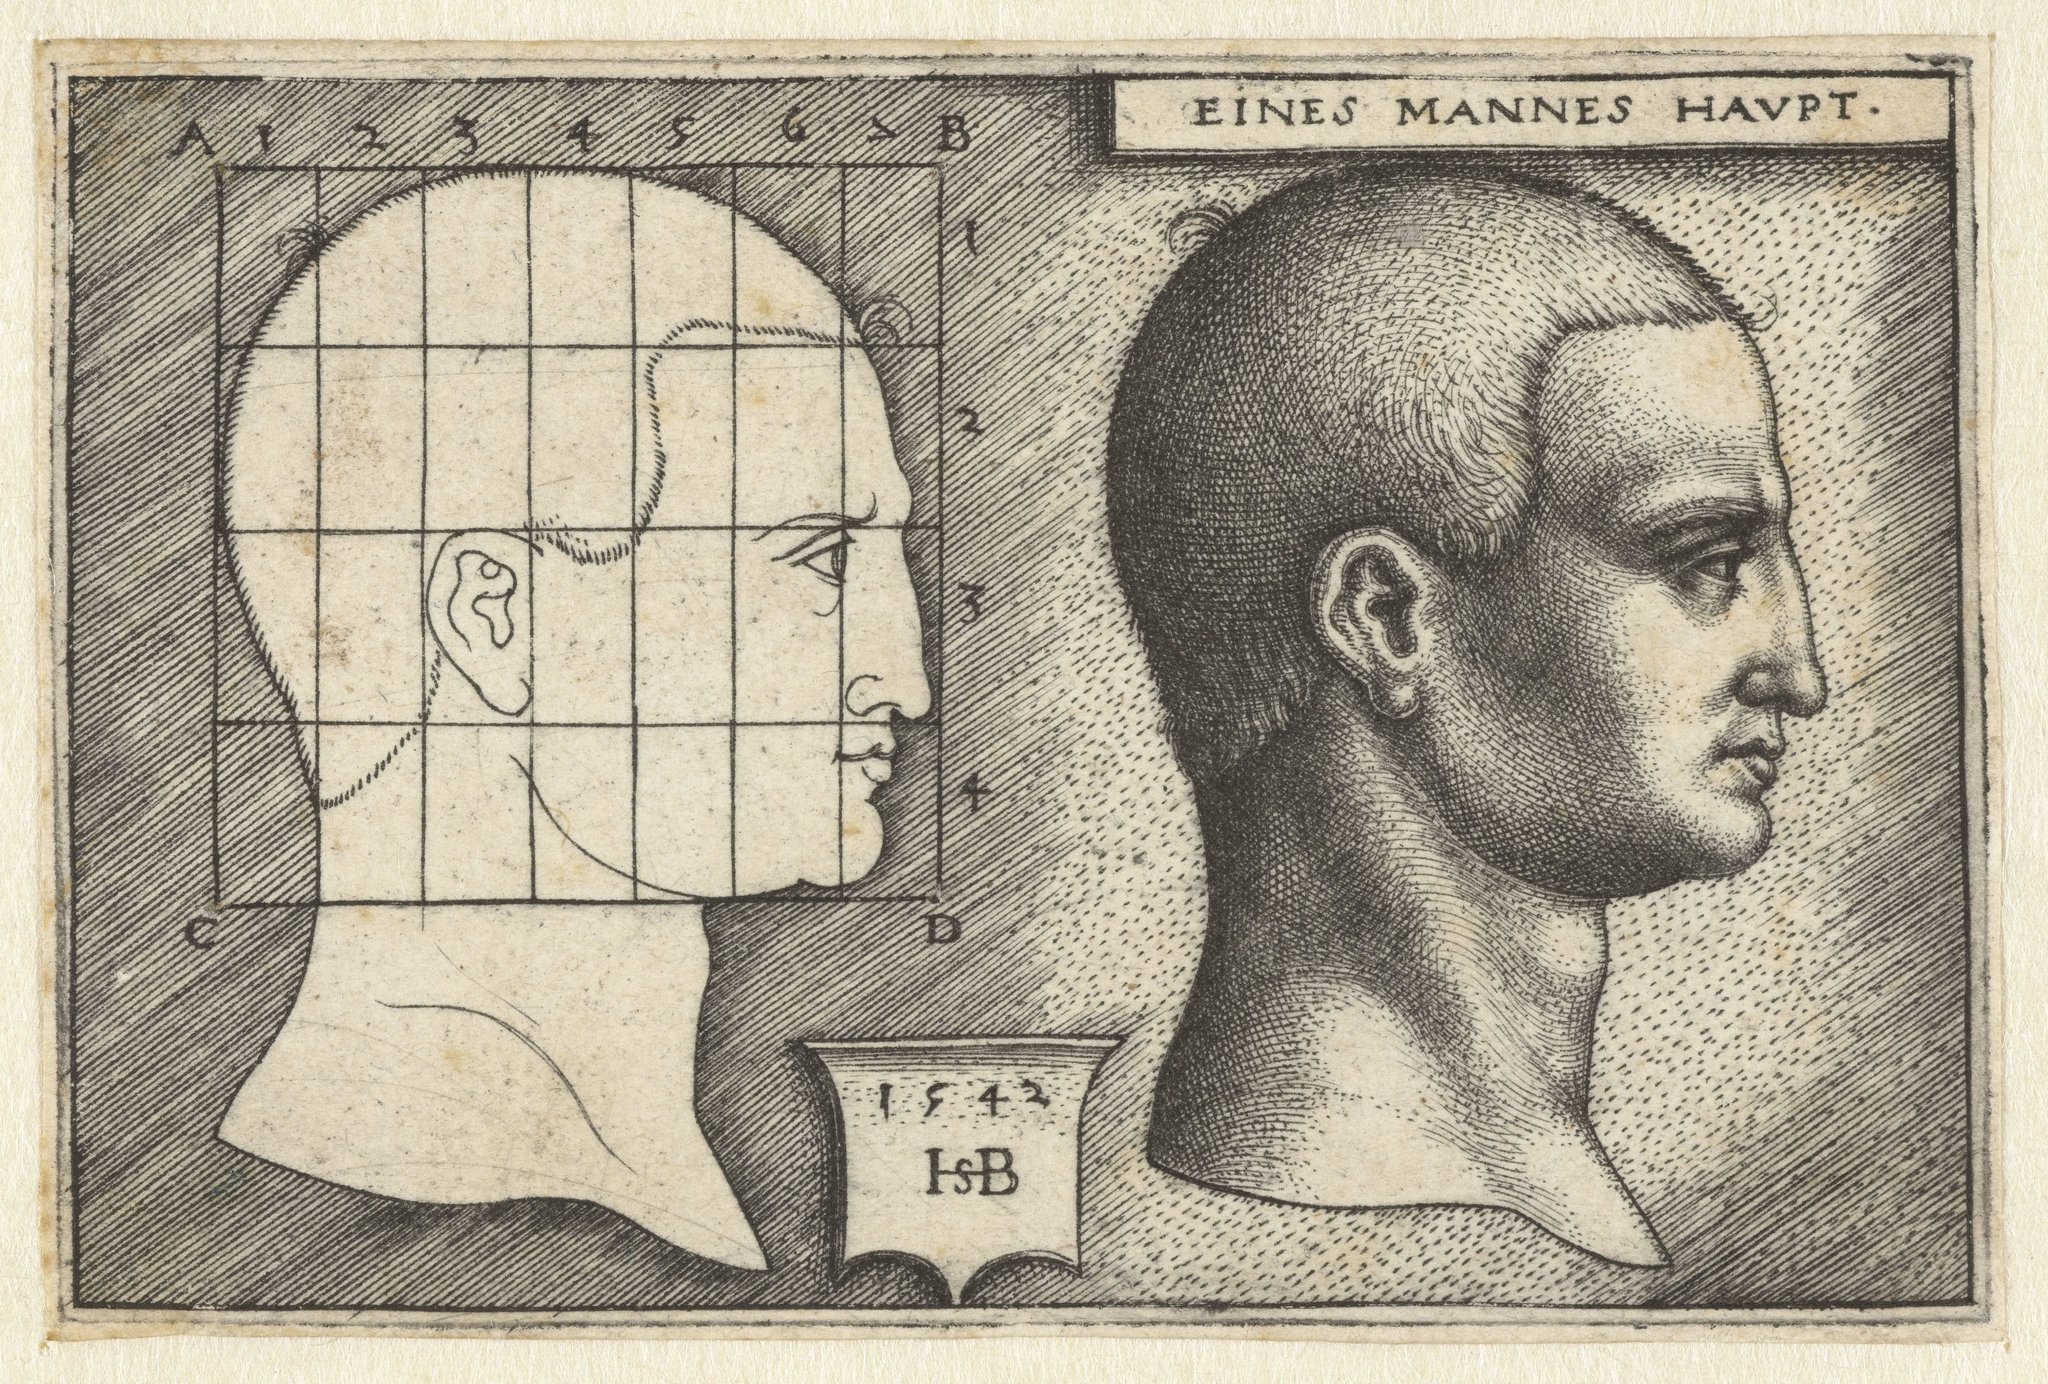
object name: print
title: Mannenhoofd en tekening in schema volgens proportieleer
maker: hans sebald beham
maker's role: designer, draughtsman, print maker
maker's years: 1500-1550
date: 1542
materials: paper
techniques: engraving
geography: frankfurt am main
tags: head (human), canon, proportions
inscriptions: collector's mark: Lugt 2228a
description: Mannenhoofd en lijntekening in schema volgens de proportieleer, waarschijnlijk van Albrecht Dürer.